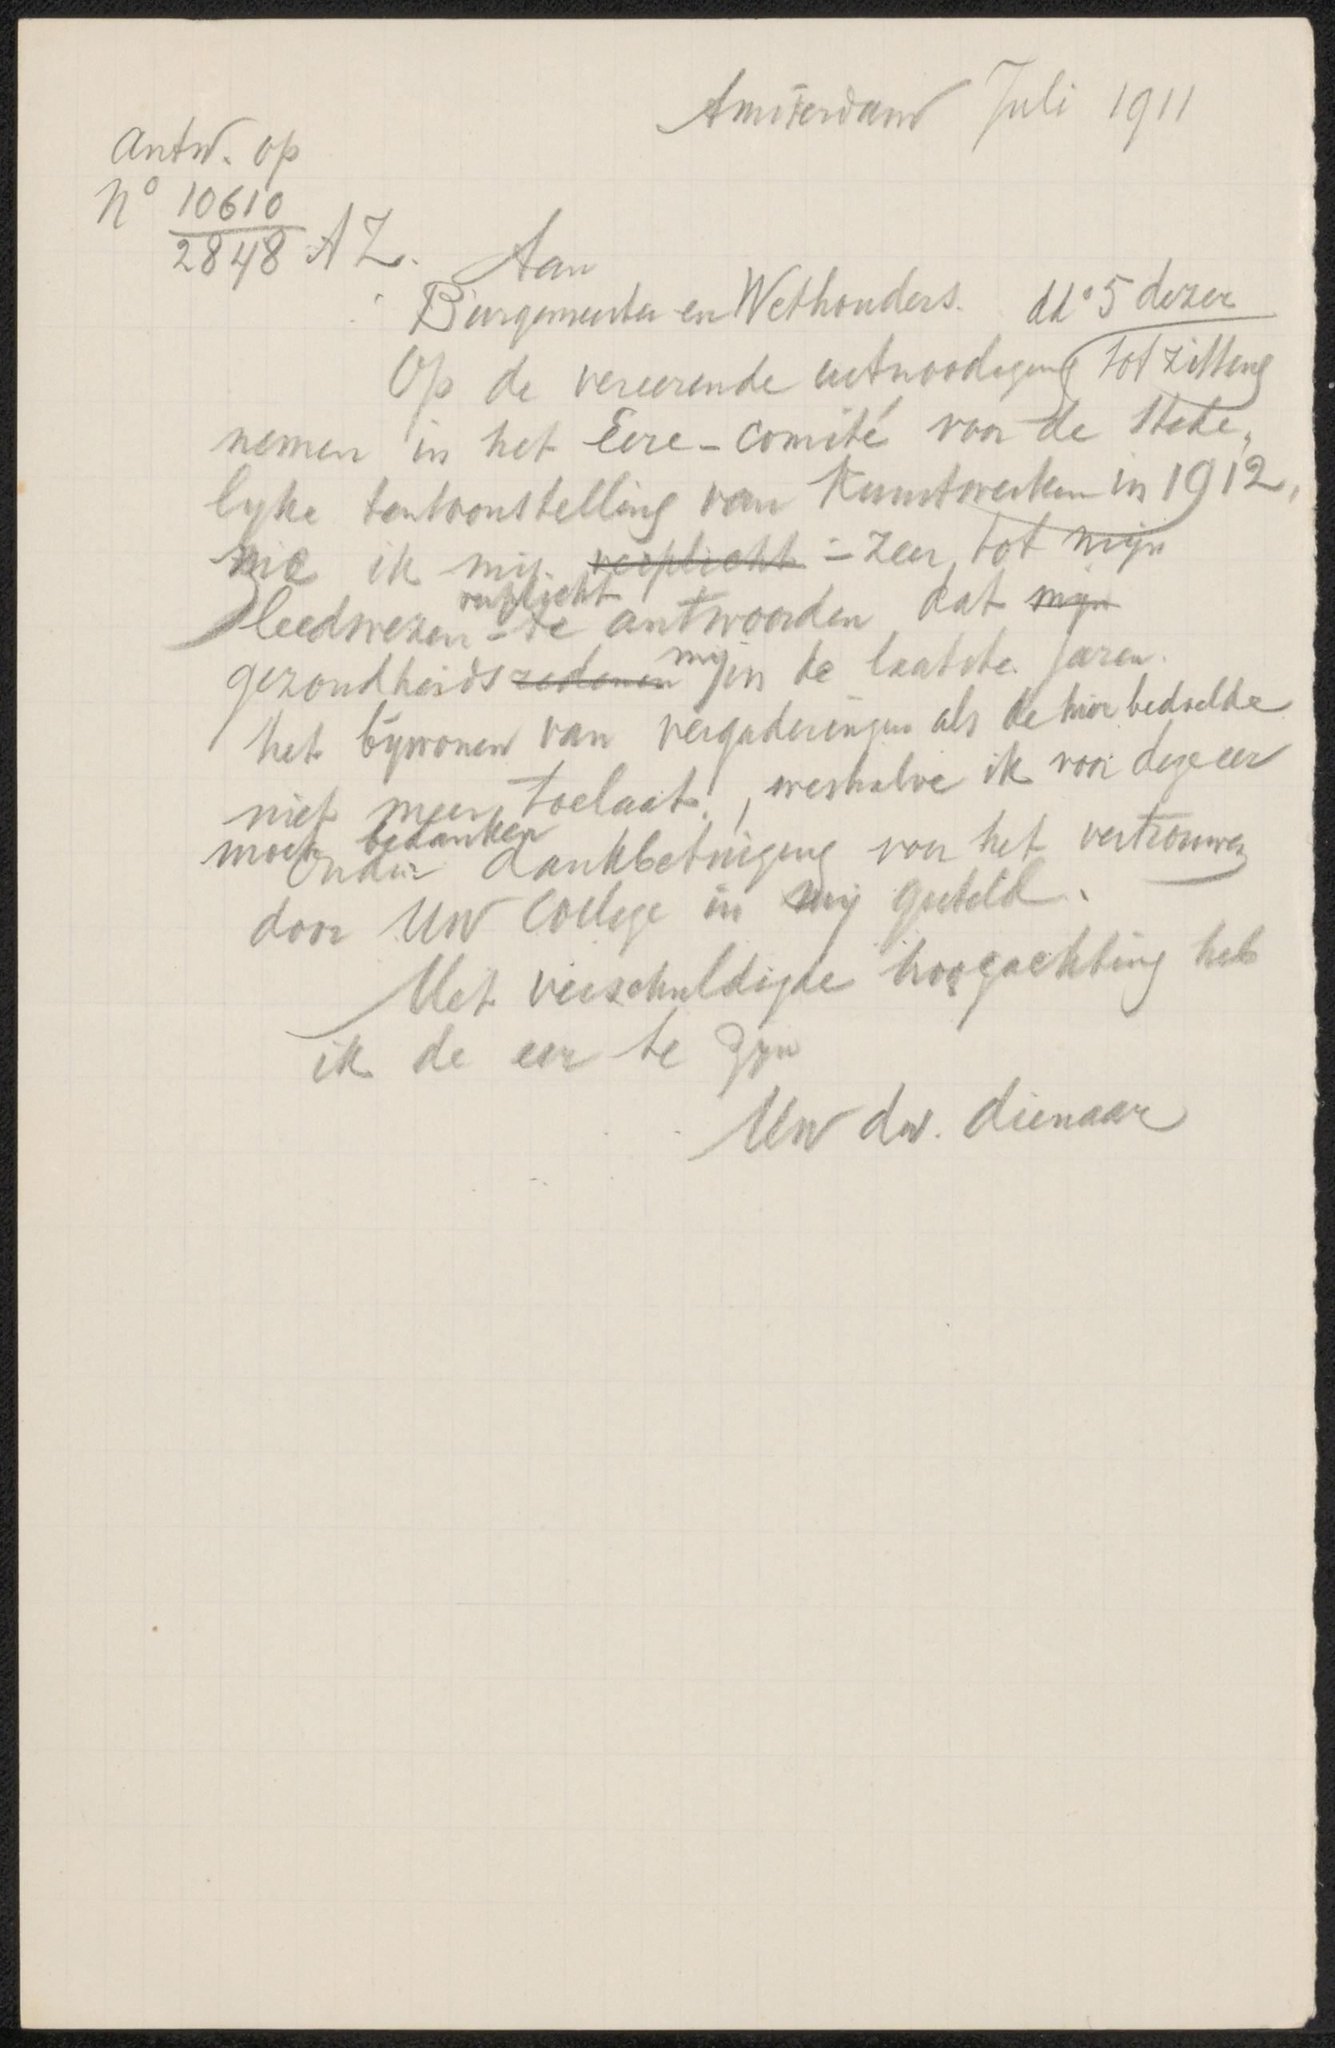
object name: letter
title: Brief aan Burgemeester en Wethouders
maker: august allebé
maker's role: draughtsman, print maker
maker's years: 1838-1927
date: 1907-1911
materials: pencil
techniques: writing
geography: amsterdam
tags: exhibition ~ art, diseases